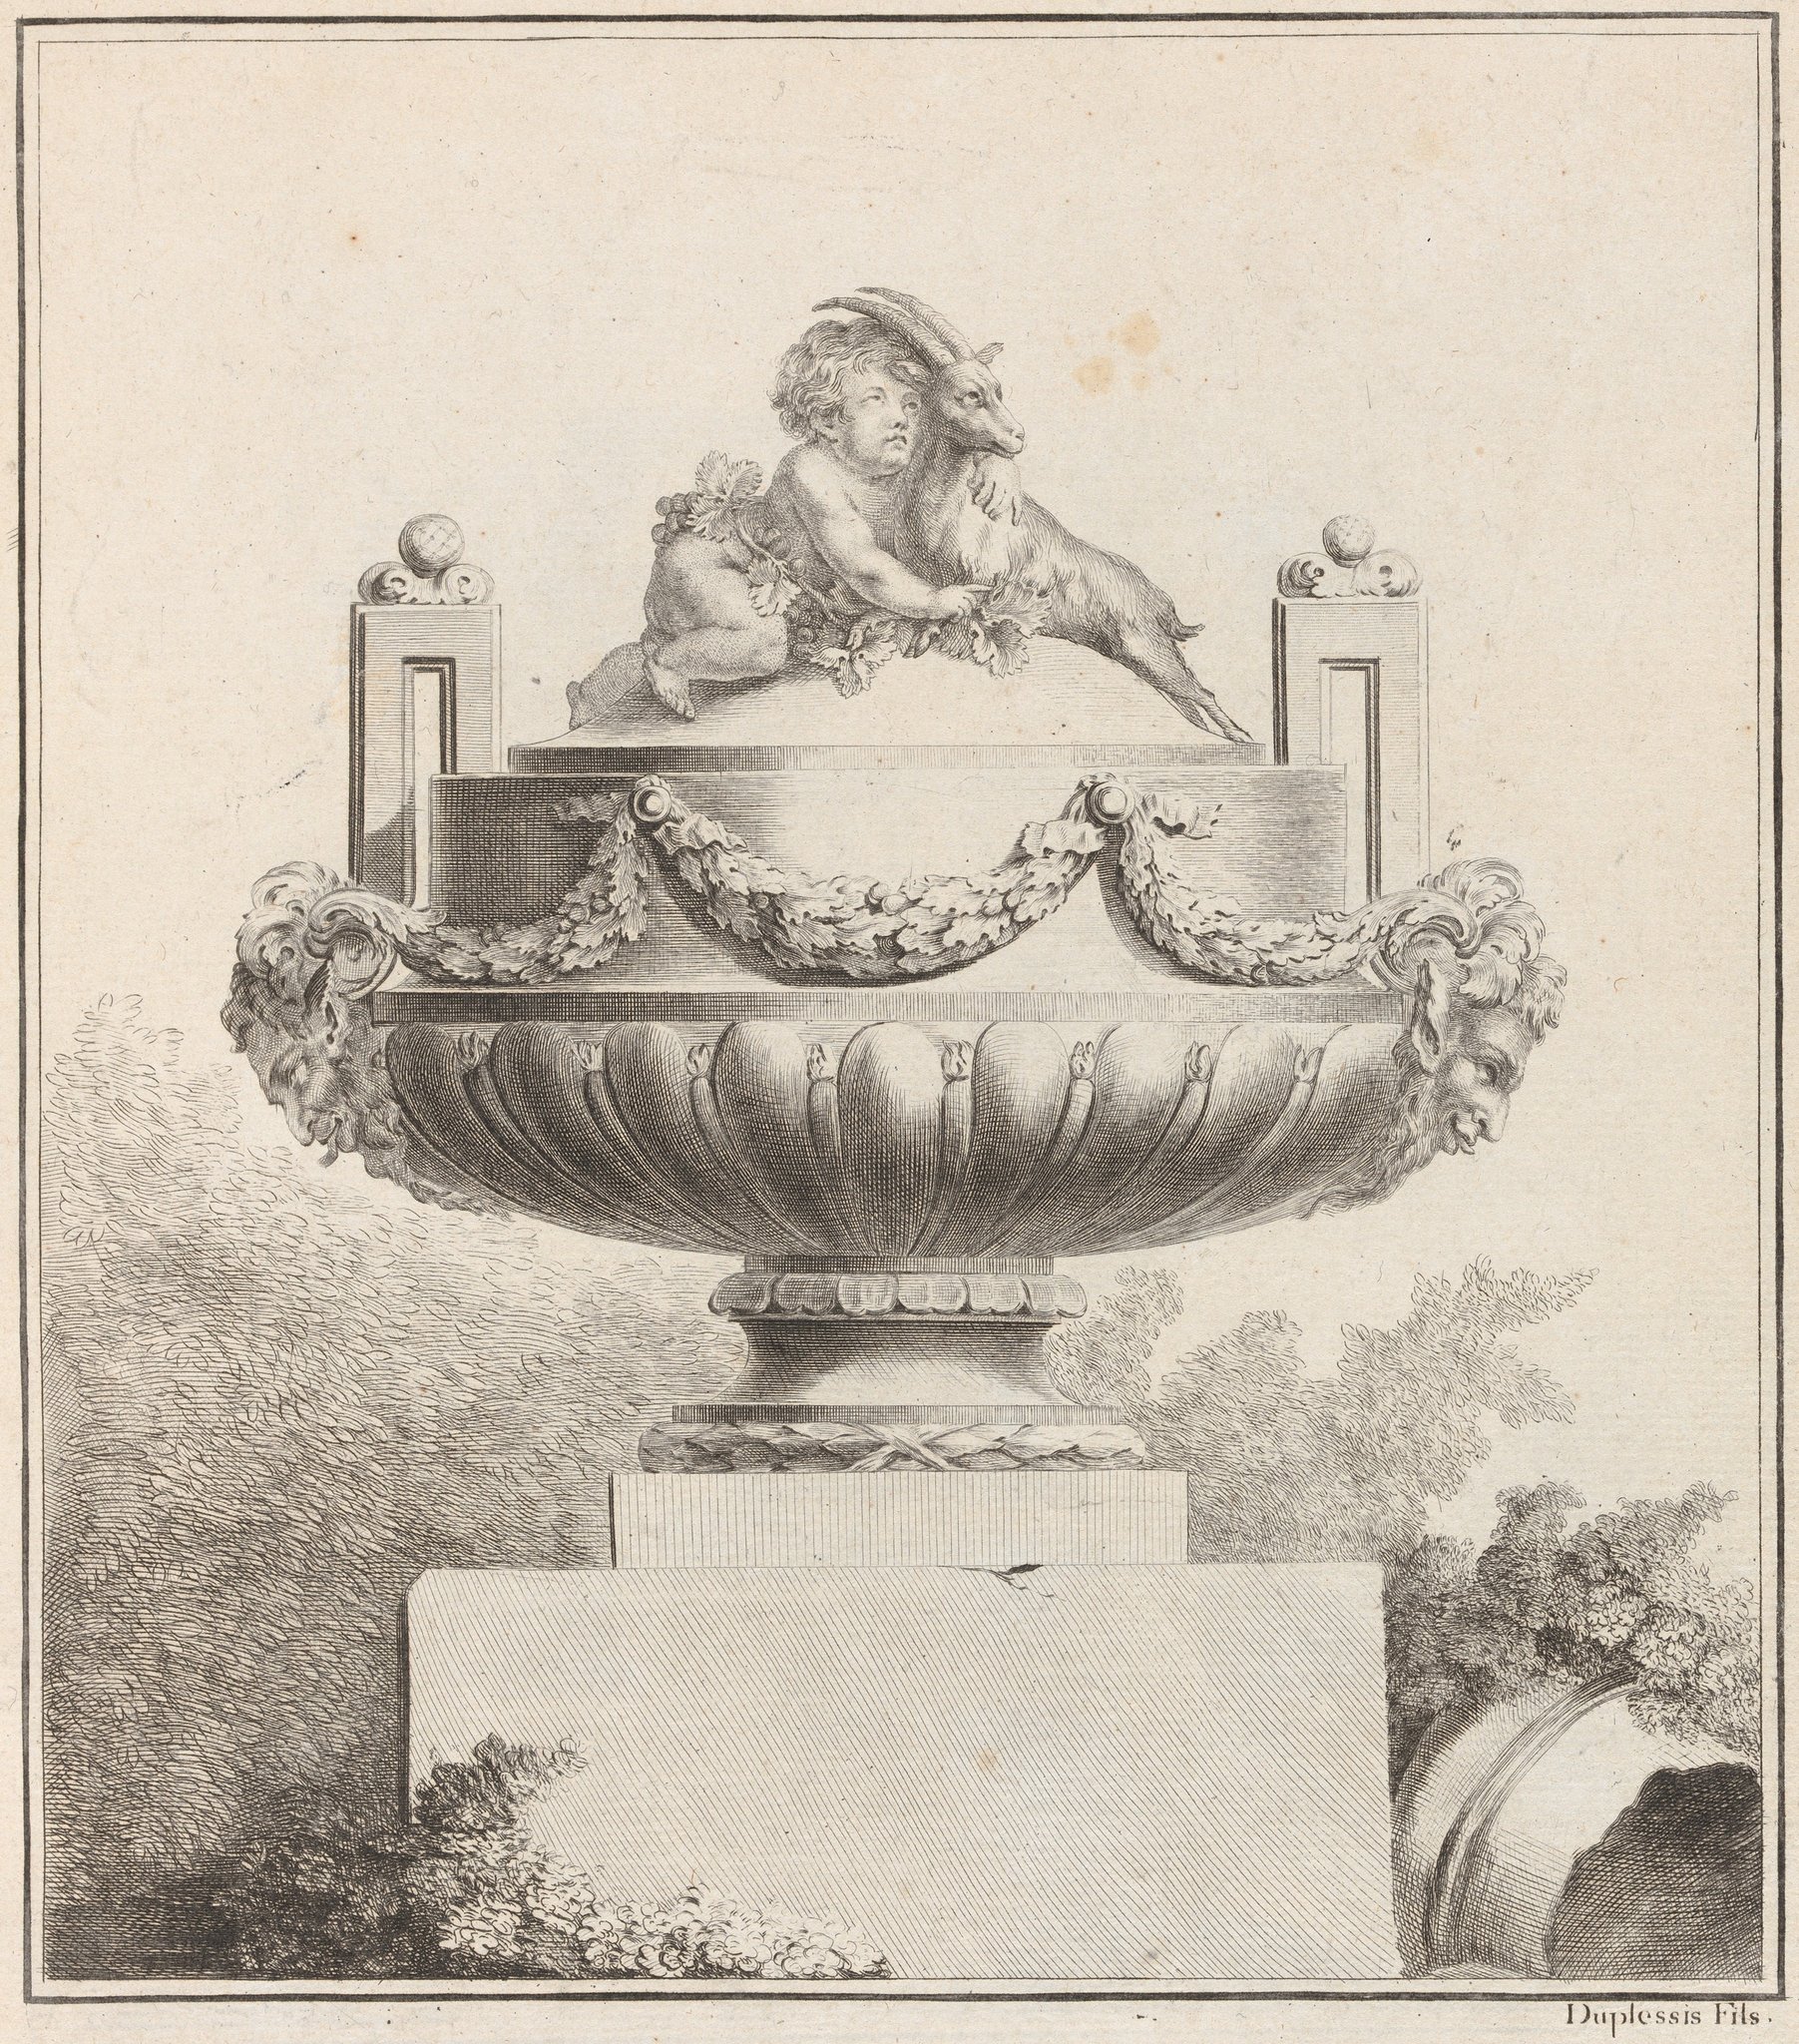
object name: book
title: Premiere Suite de Vases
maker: duplessis fils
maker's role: artist and publisher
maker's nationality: french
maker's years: 18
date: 1701-1800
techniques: etching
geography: france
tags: putti,goats,vases